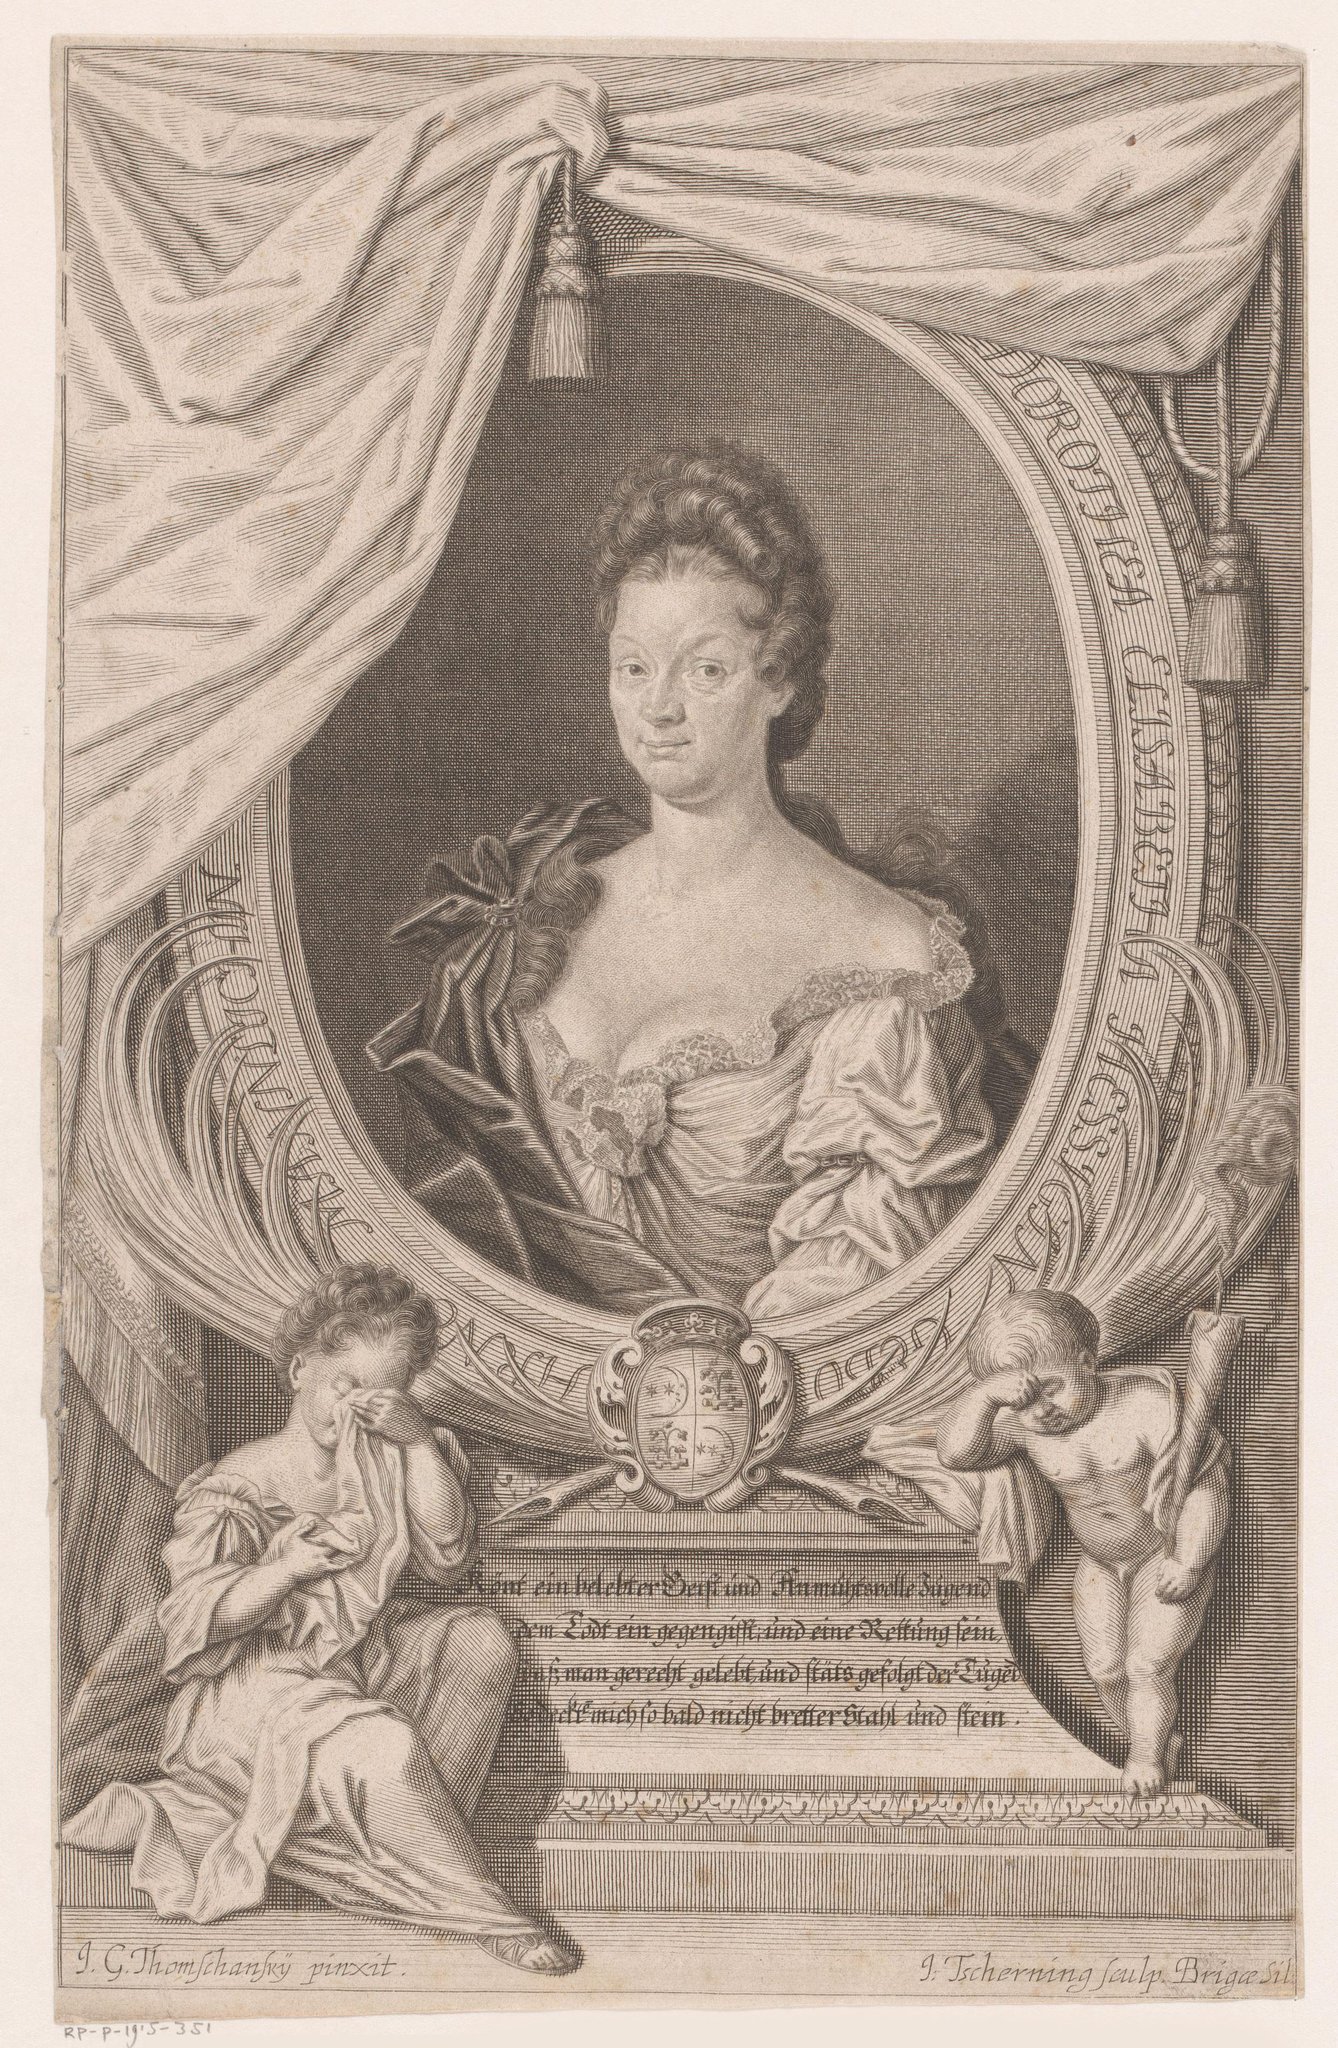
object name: print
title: Portret van Dorothea Elisabeth Hessig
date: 1700-1729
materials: paper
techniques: engraving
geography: breslau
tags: historical persons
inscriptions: collector's mark: Lugt 2228